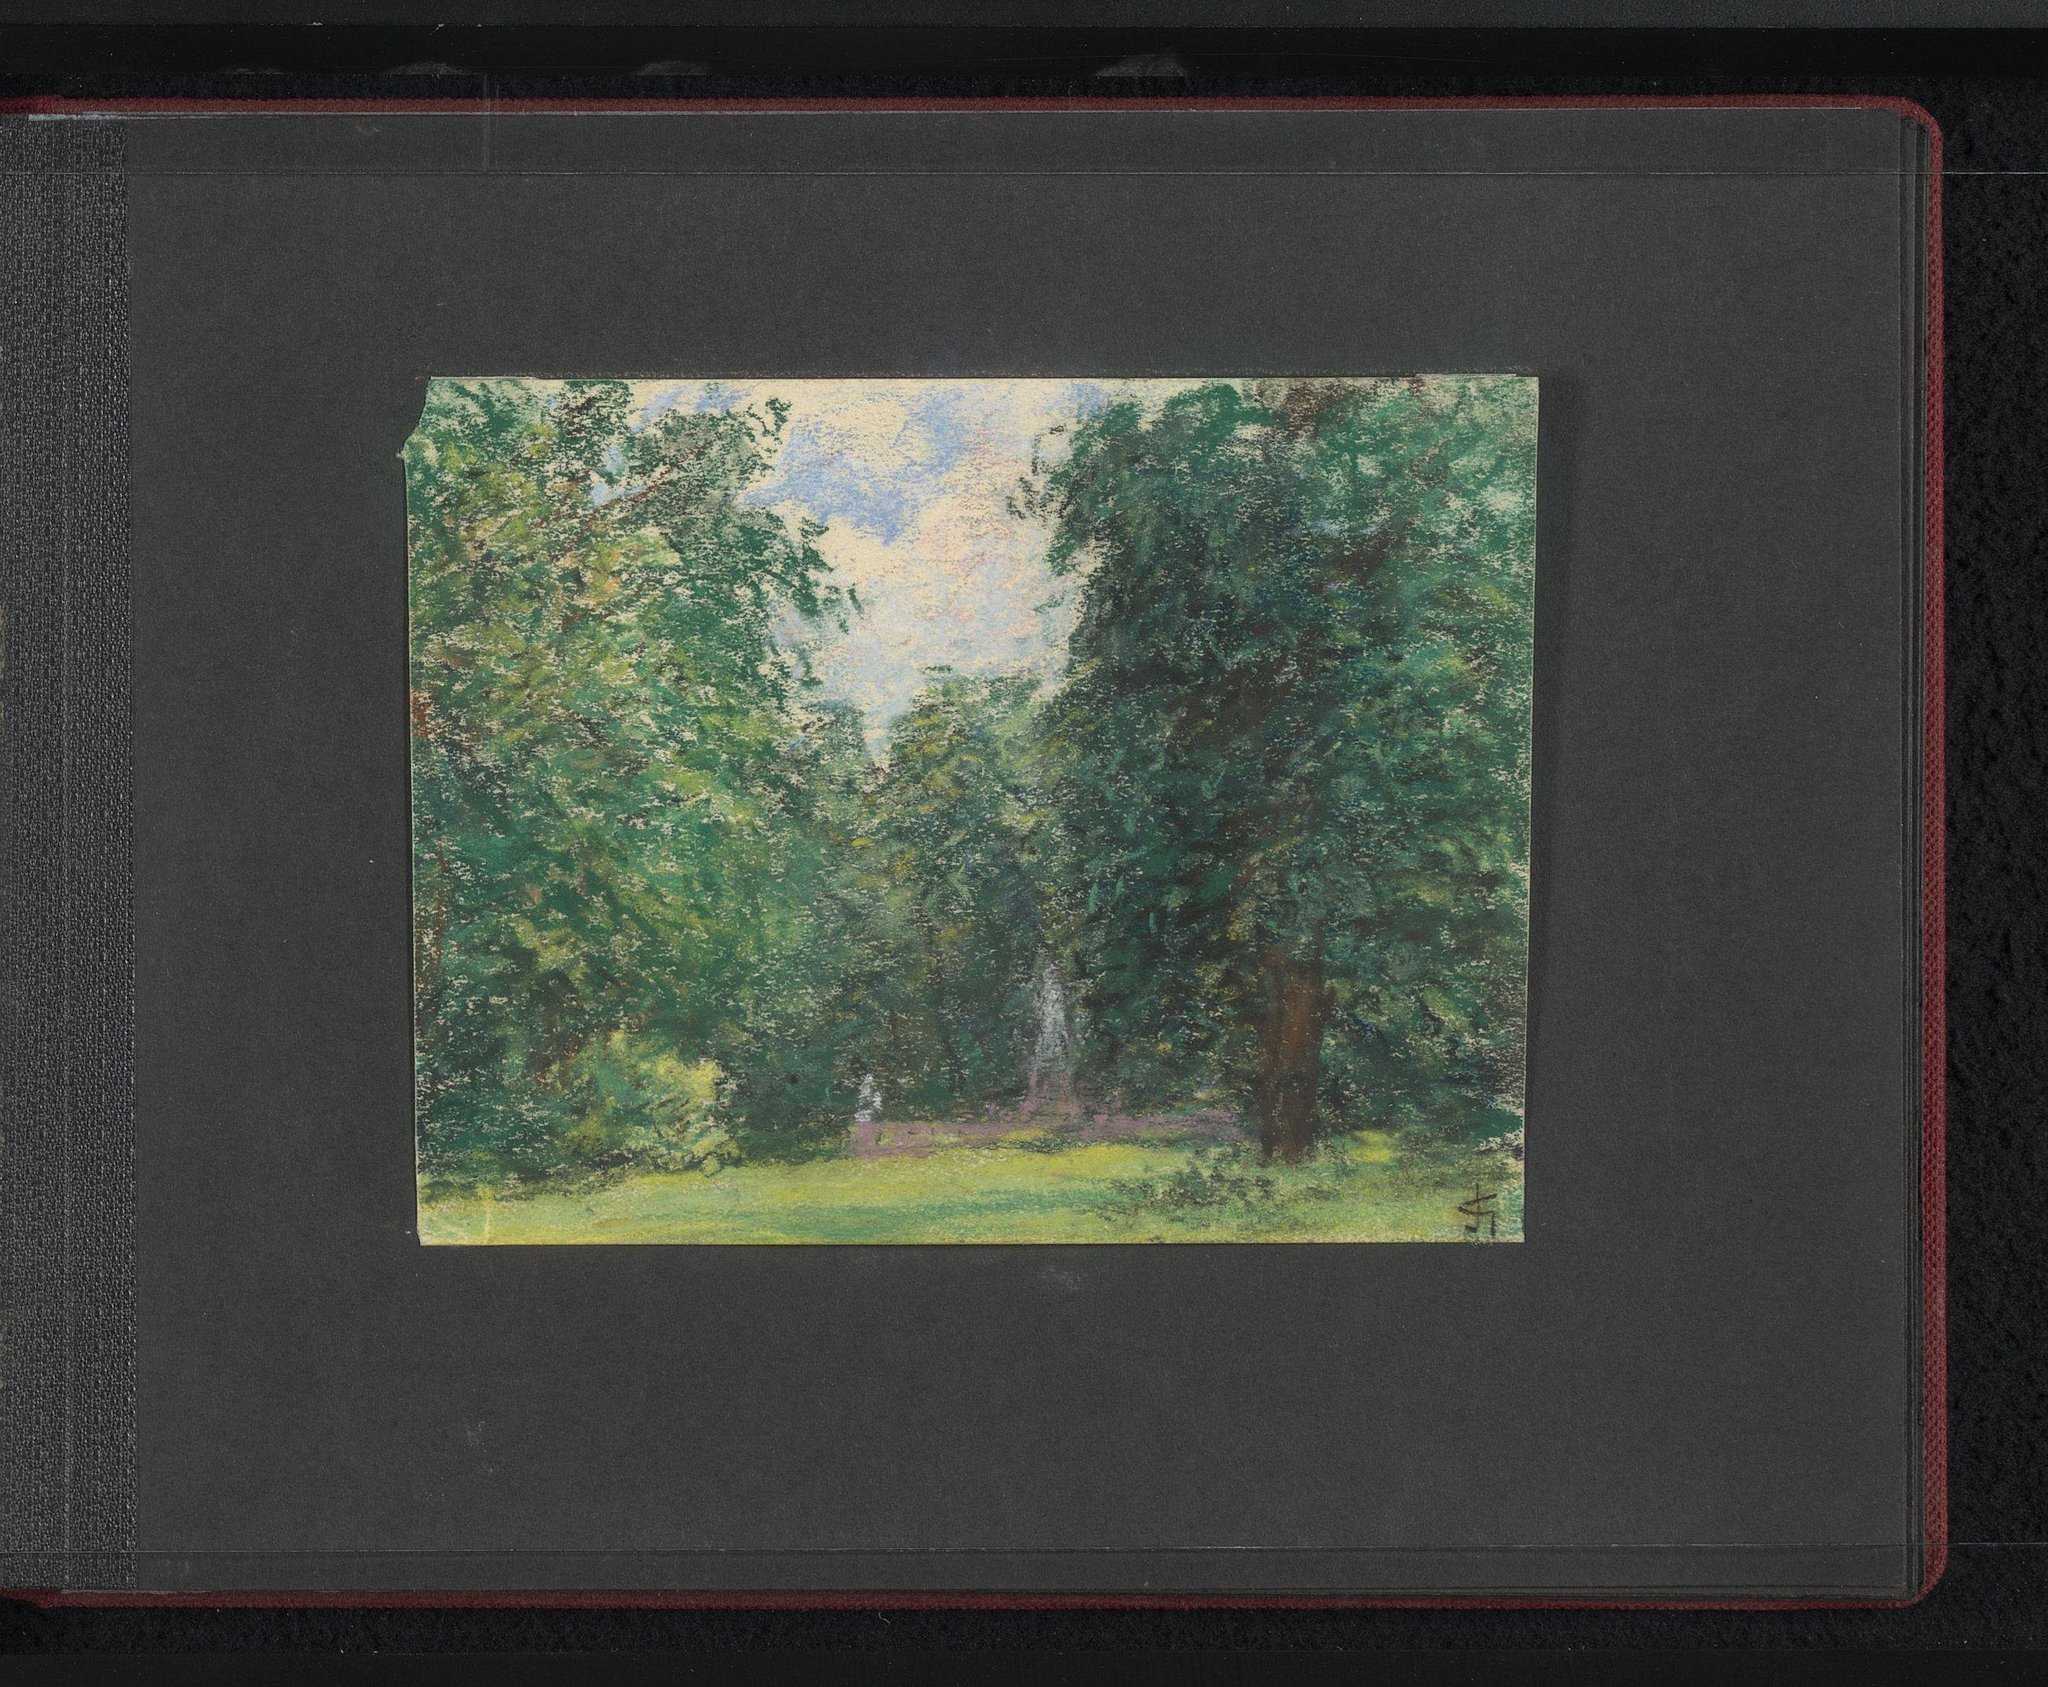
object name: drawing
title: Open plek omringd door bomen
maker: carel nicolaas storm van s-gravesande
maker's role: draughtsman, print maker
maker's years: 1841-1924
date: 1915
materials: chalk, paper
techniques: pasting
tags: trees, public gardens, park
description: Mogelijk in het Kurpark te Wiesbaden. Tekening maakt deel uit van een album.